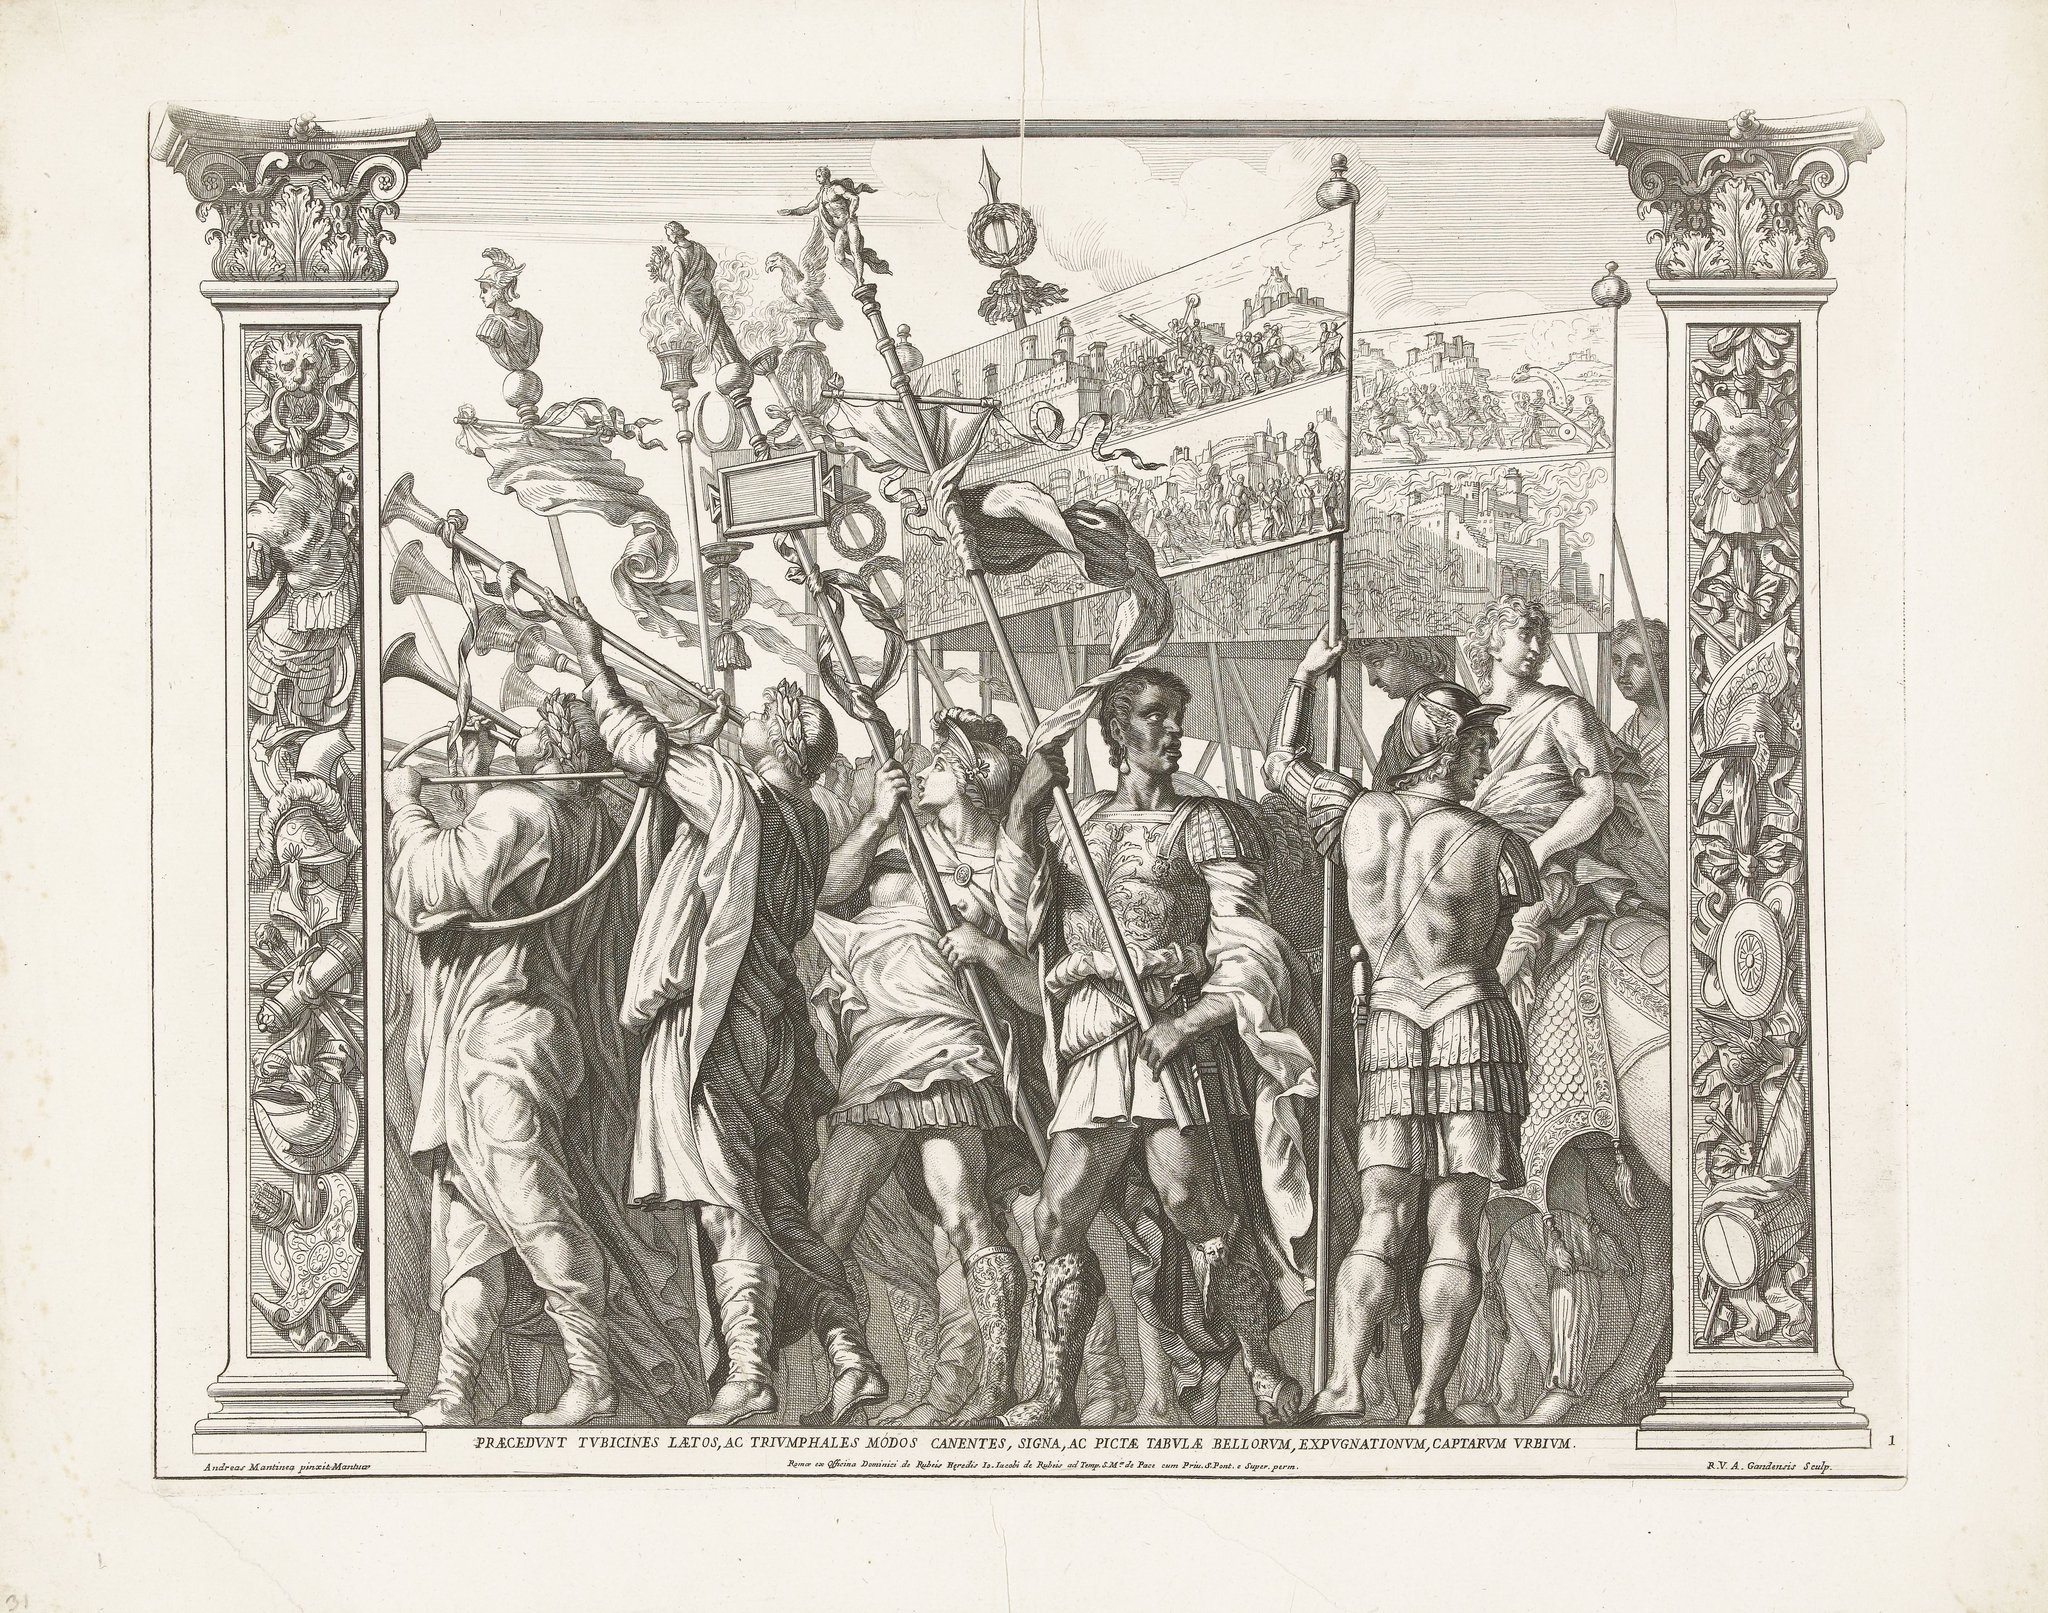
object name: print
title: Soldaten dragen spandoeken met de heldendaden van Caesar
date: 1692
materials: paper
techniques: engraving, etching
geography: rome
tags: triumph of caesar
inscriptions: collector's mark: Lugt 240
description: Soldaten uit de verschillende landstreken van het Heilige Roomse Rijk lopen mee in een optocht ter ere van Julius Caesar. Ze dragen spandoeken met scènes van succesvolle belegeringen van steden.